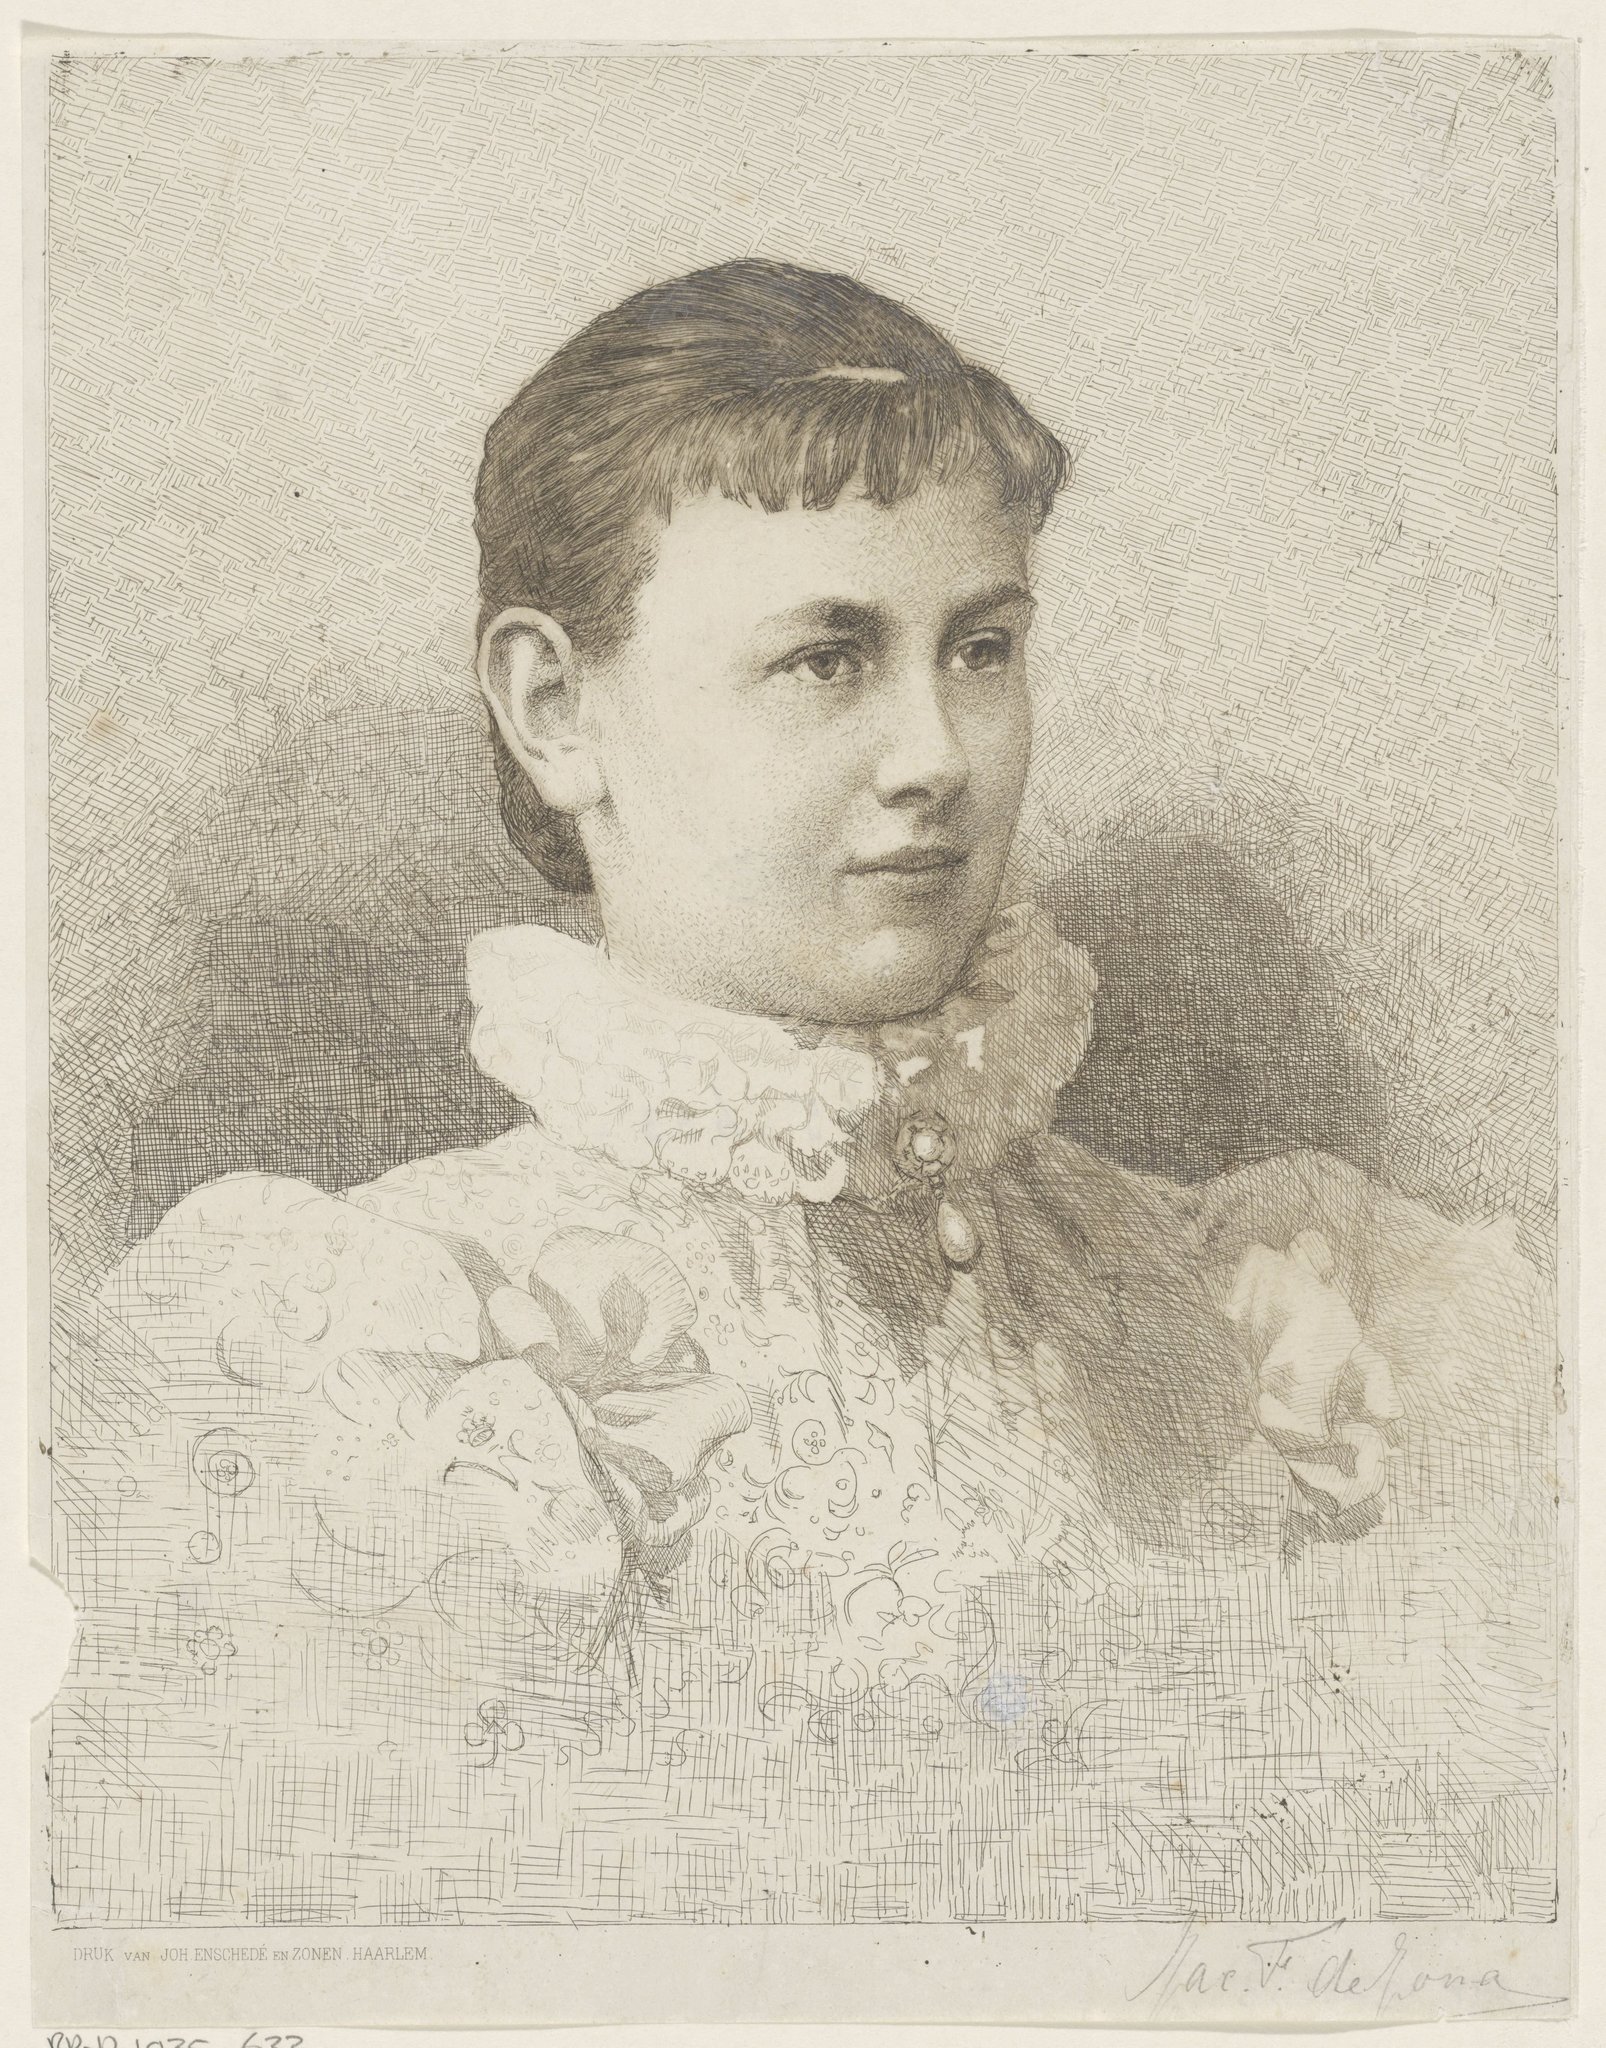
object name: print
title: Portret van Wilhelmina, koningin der Nederlanden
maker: jacobus frederik sterre de jong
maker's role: print maker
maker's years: 1866-1920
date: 1896-1920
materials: paper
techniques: drypoint, etching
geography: haarlem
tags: the hague, print maker, wilhelmina of the netherlands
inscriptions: collector's mark: Lugt 2760, collector's mark: Lugt 2228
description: De hier vermelde titel verwijst naar de hoogst verkregen titel van de geportretteerde, niet per se naar de titel die de geportretteerde op deze voorstelling draagt.